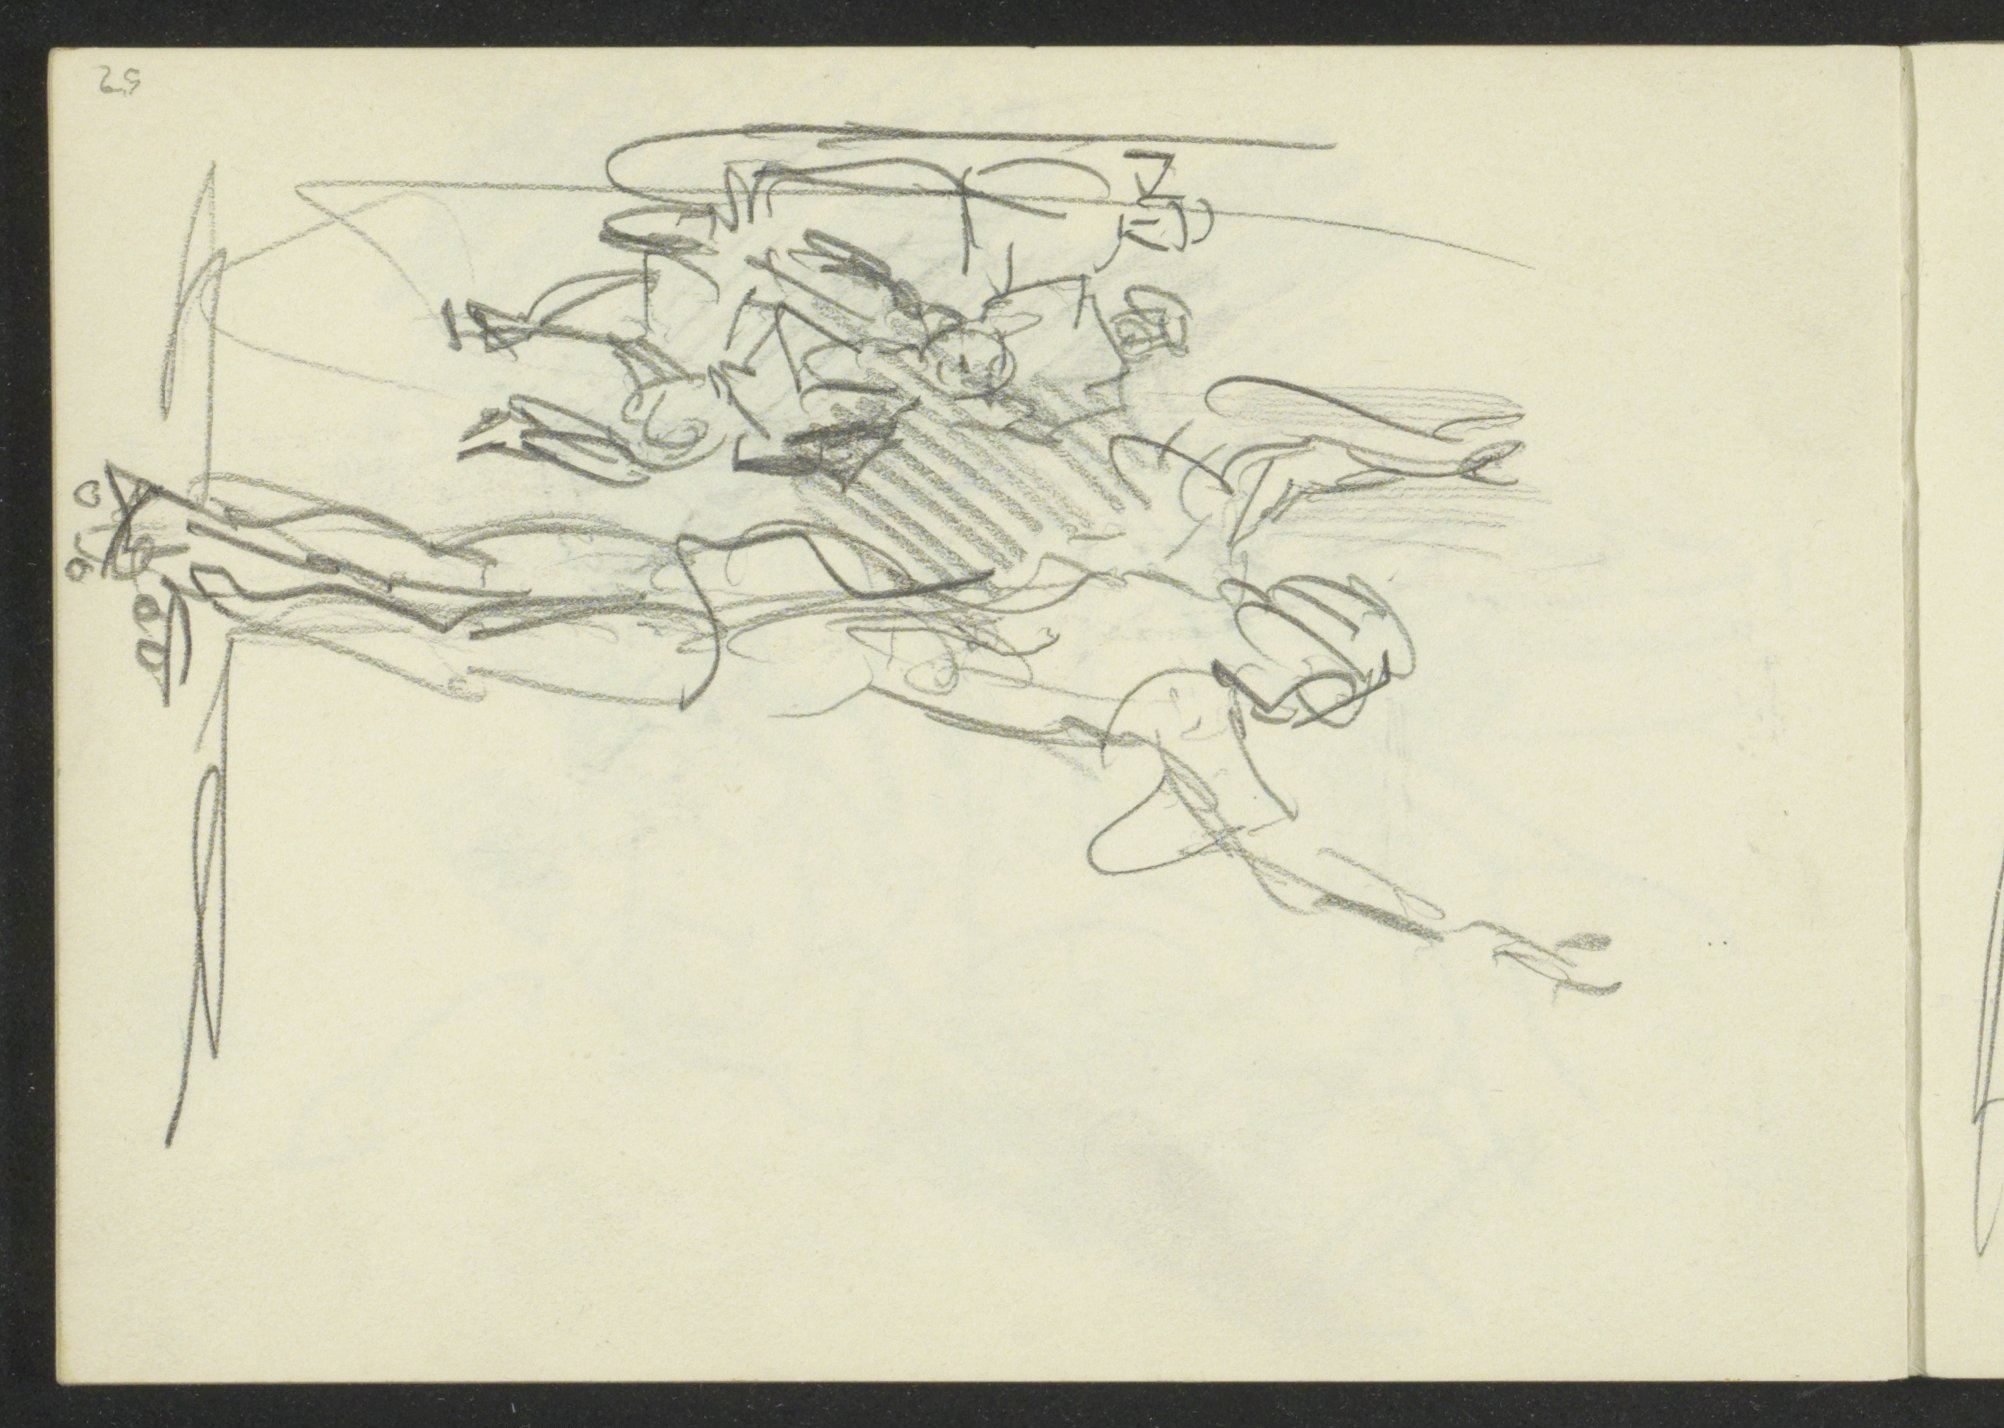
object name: sketchbook leaf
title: Artiest op rolschaatsen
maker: isaac israels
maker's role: draughtsman, painter, print maker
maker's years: 1865-1934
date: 1875-1934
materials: paper, pencil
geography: the hague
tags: roller-skating, roller-skates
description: Met de armen in de lucht. Op de achtergrond nog enkele figuren. Blad 7 verso uit schetsboek LVII met 29 bladen.